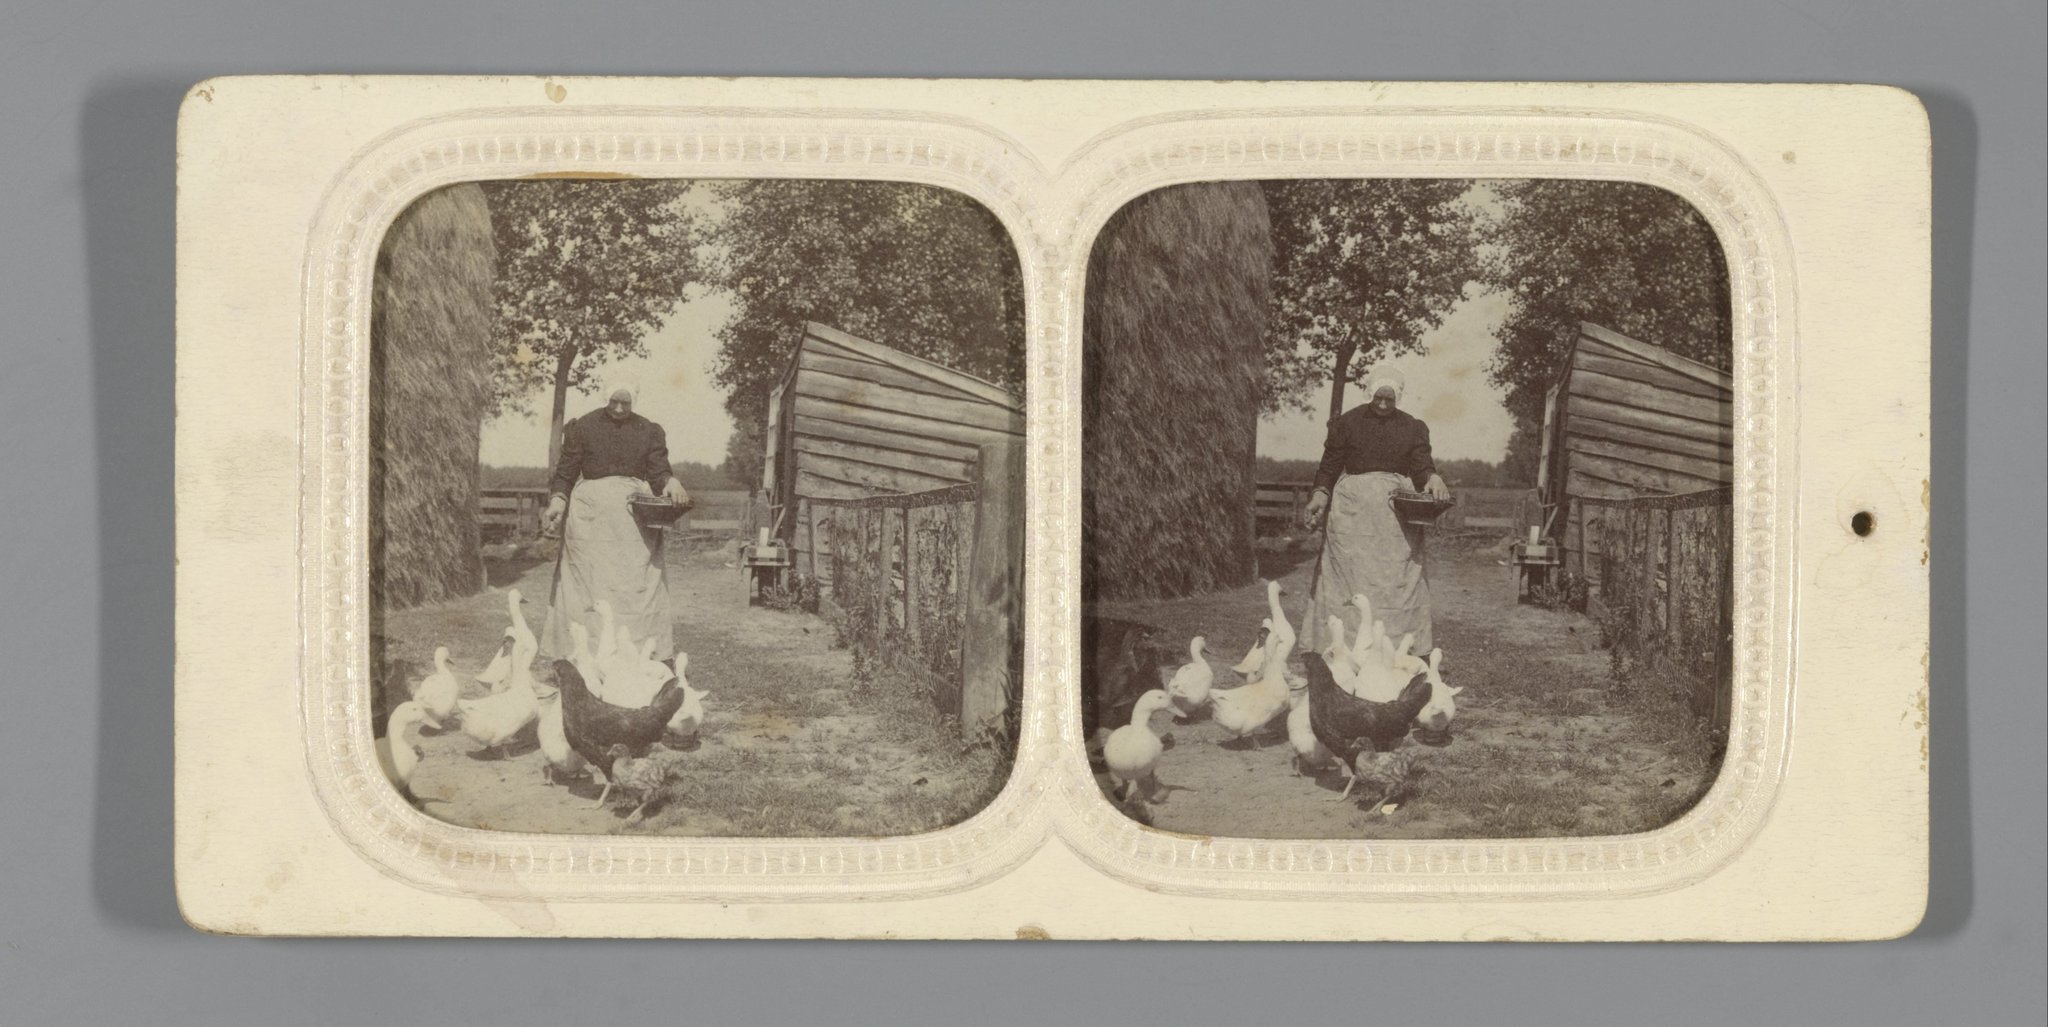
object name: tissue stereograph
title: Boerin voedert ganzen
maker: Anonymous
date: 1855-1875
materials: cardboard, paper, photographic support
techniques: albumen print, hand coloring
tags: water-birds: goose, farmers - aa - female farmer, farmer's wife